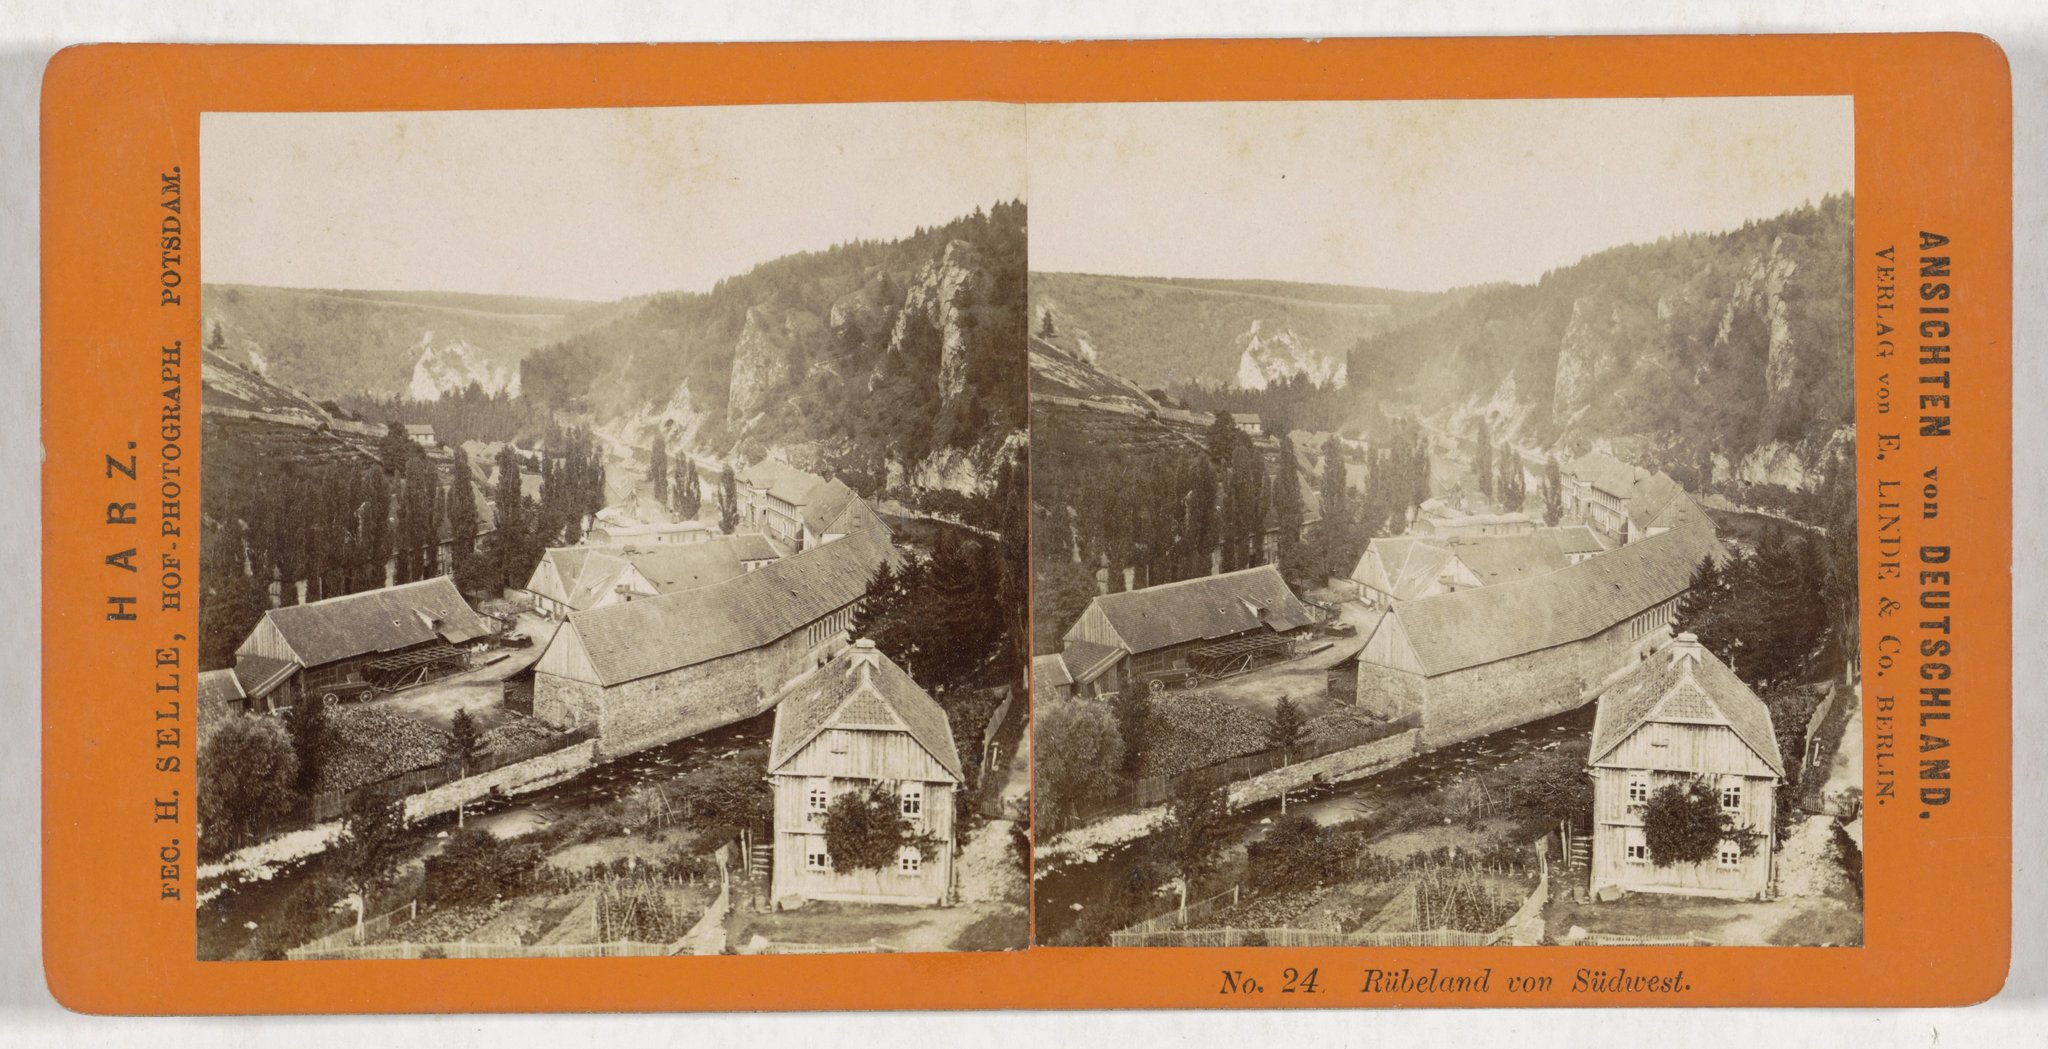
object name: stereograph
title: Rübeland, gezien vanuit het zuidwesten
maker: hermann selle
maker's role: fotograaf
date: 1868-1890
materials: cardboard, paper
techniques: albumen print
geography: berlin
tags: low hill country, village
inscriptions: inscription: ‘No. 24. Harz. Rübeland von Südwest./ Vom Glockenberge oberhalb (...) Raubburgen standen. (W.Riehl)’, number: ‘No. 24.’, inscription: ‘Hof-Photograph. Potsdam.’